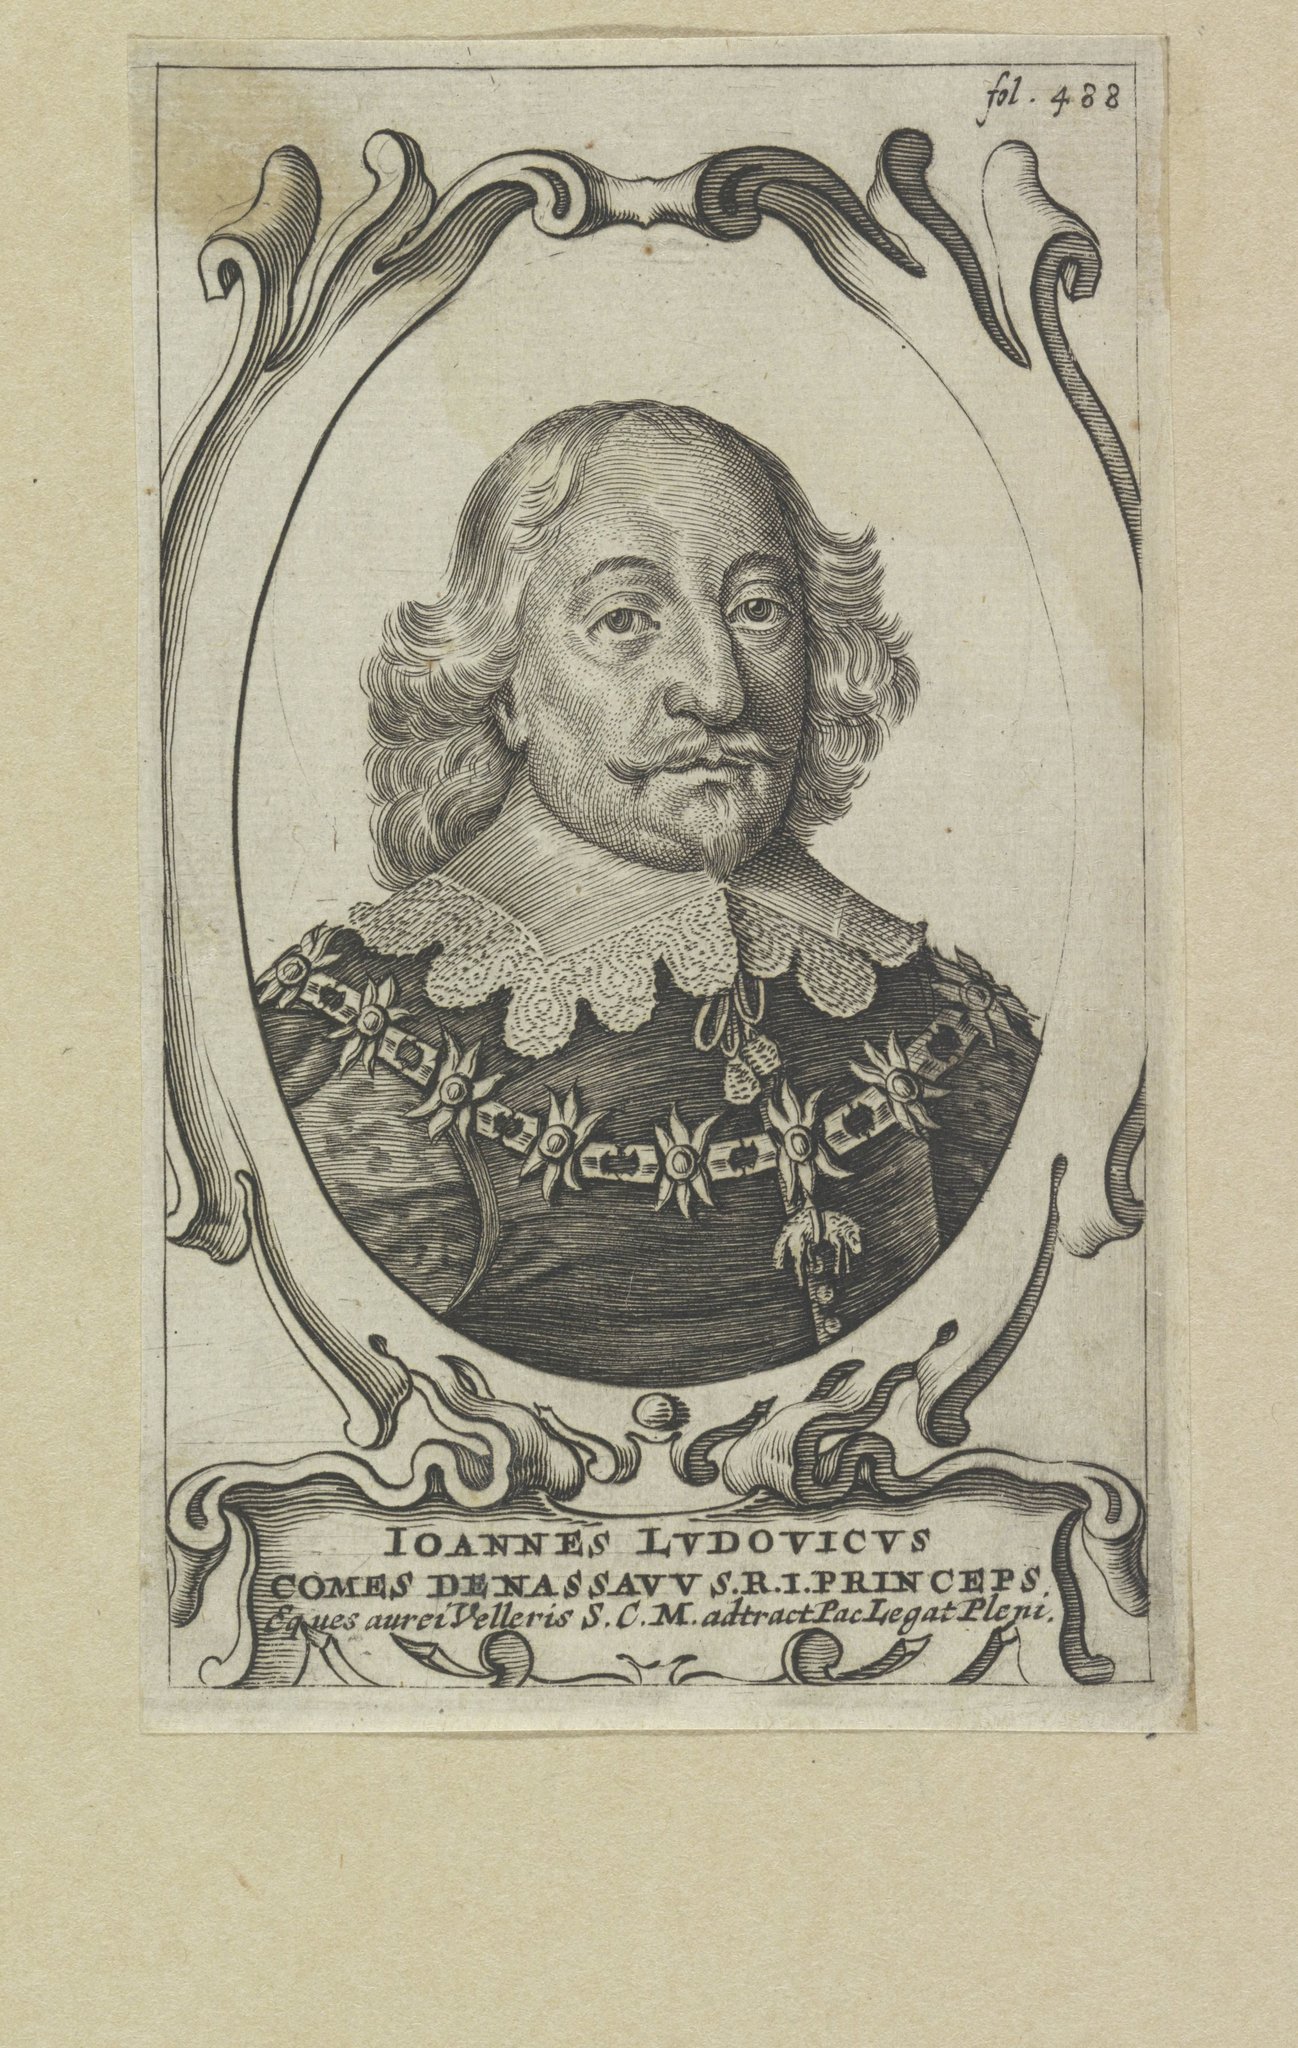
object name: book illustration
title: Portret van Johan Lodewijk, graaf van Nassau-Hadamar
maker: Anonymous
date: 1600-1699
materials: paper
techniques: engraving, etching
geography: low countries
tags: knighthood order of the golden fleece - insignia of a knighthood order, e.g.: badge, chain (with name of order)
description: De hier vermelde titel verwijst naar de hoogst verkregen titel van de geportretteerde, niet per se naar de titel die de geportretteerde op deze voorstelling draagt.